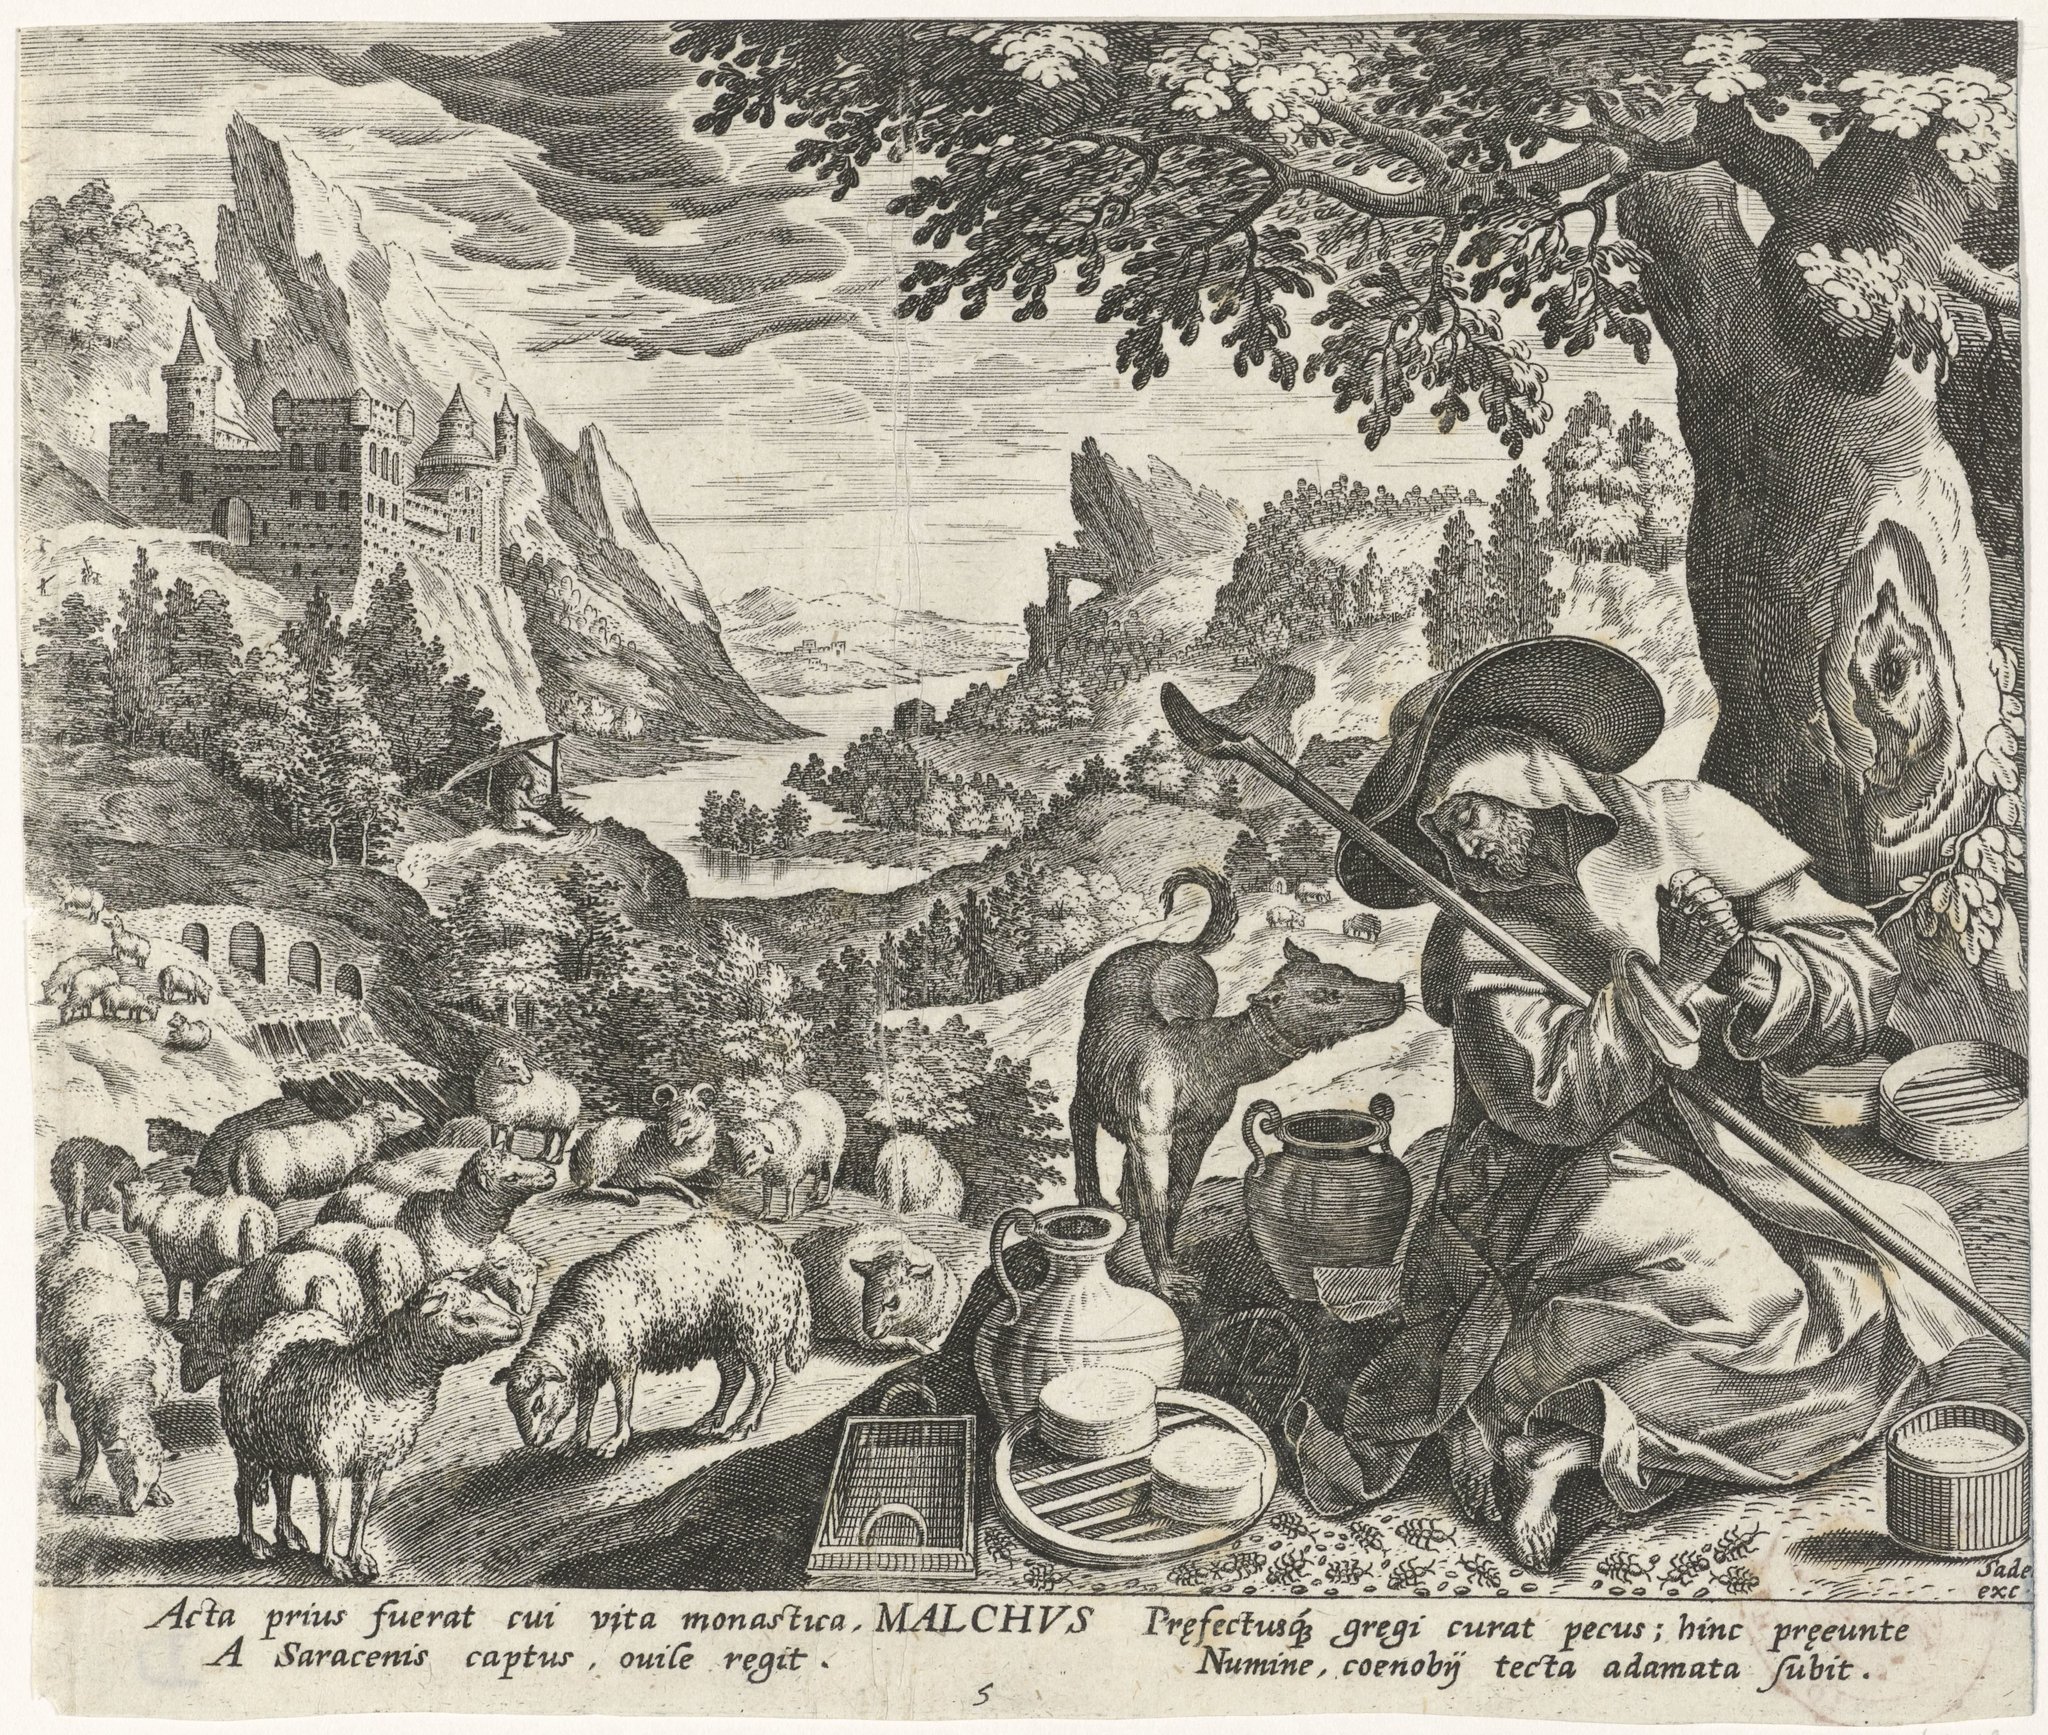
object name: print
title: Solitudo Sive Vitae Patrum Eremicolarum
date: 1583-1588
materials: paper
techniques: engraving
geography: antwerp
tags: male saints (with name), herding, herdsman, herdswoman, shepherd, shepherdess, cowherd, etc., anchorite, hermit, sheep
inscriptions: collector's mark: Lugt 240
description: De H. Malchus van Chalcis. Hij bidt terwijl hij schapen hoedt. Op de achtergrond een hutje in het landschap met zijn vrouw, die gescheiden van haar man als non leeft.